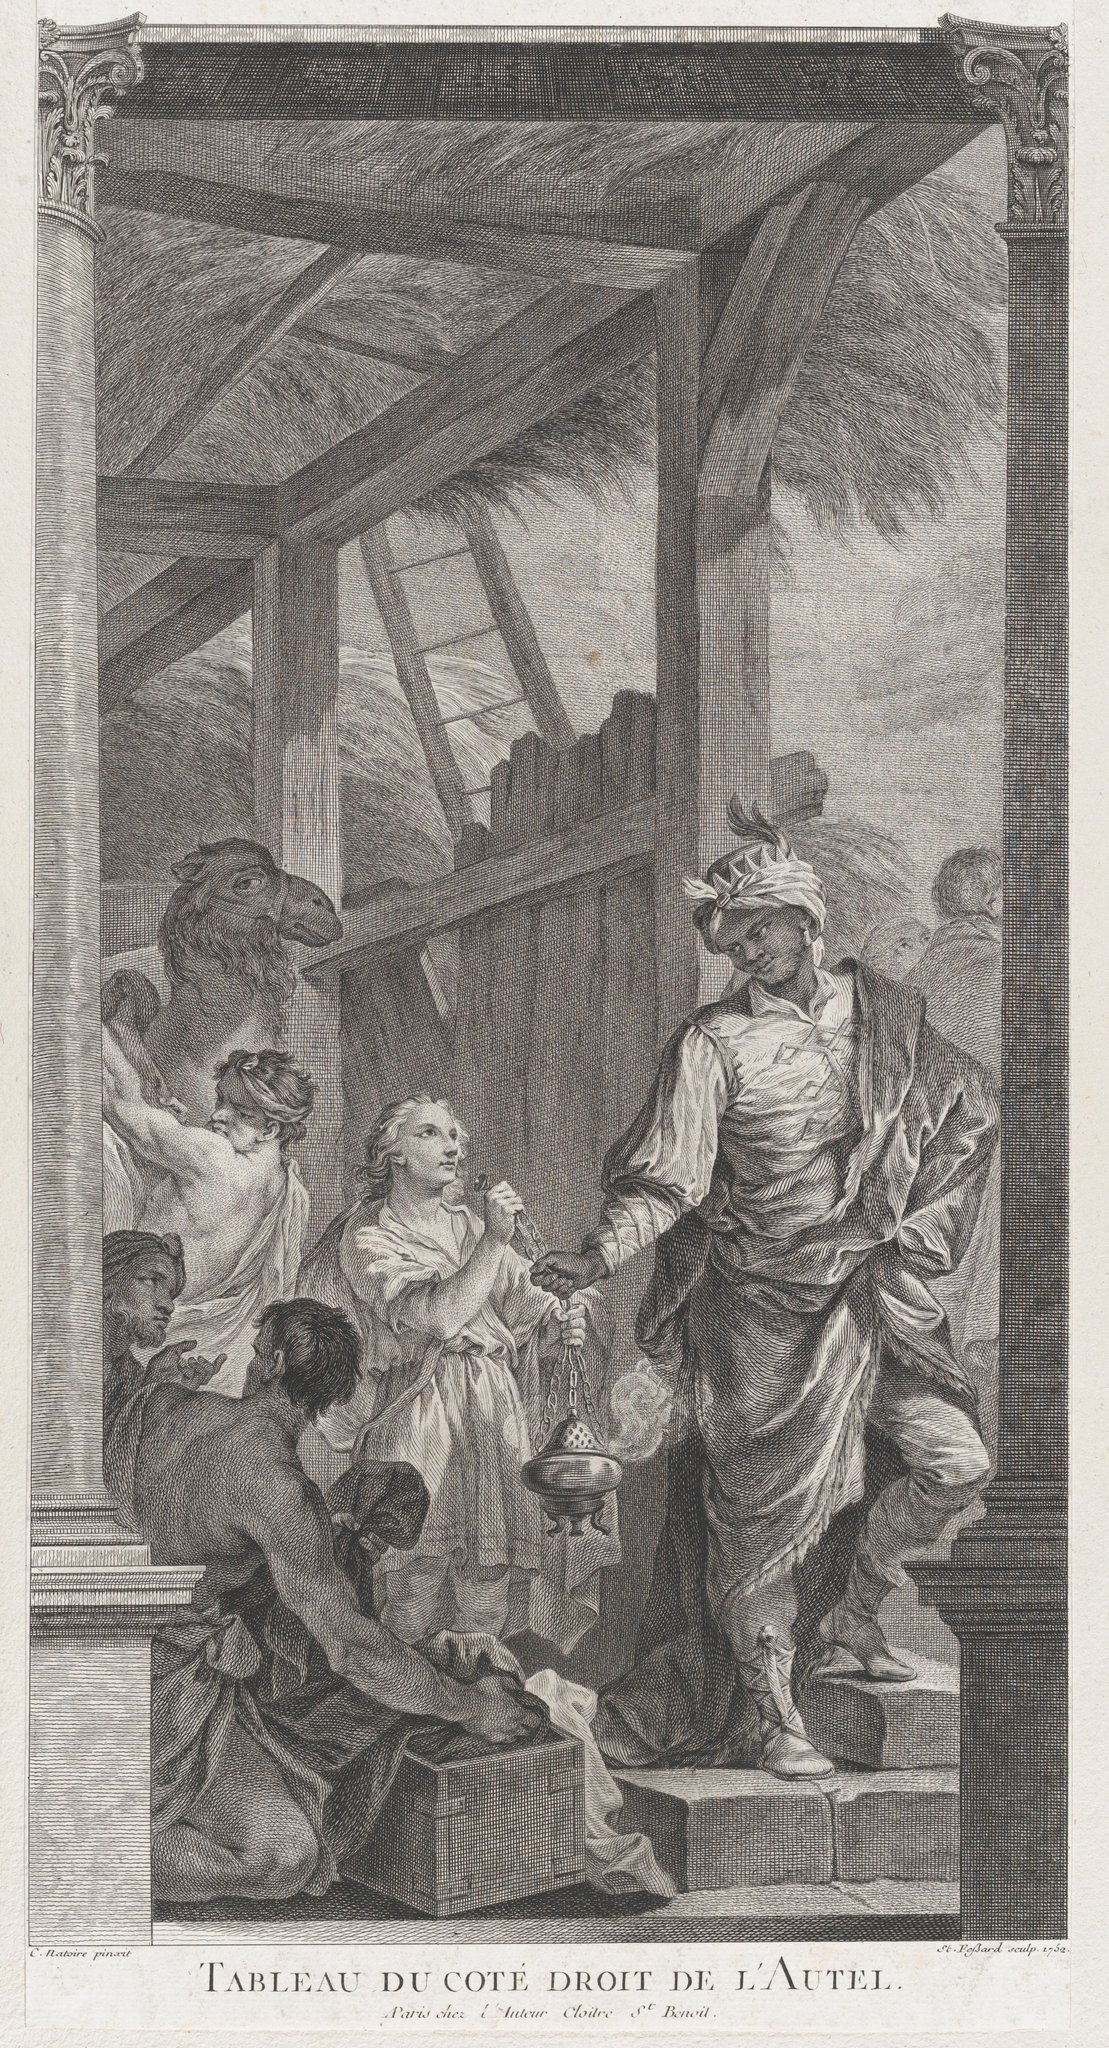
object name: print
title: The Chapel of the Enfants-Trouvés in Paris: Le Roi mage Balthazar et sa suite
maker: etienne fessard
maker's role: artist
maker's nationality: french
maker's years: 1714-1777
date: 1752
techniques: engraving, etching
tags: kings,men,camels